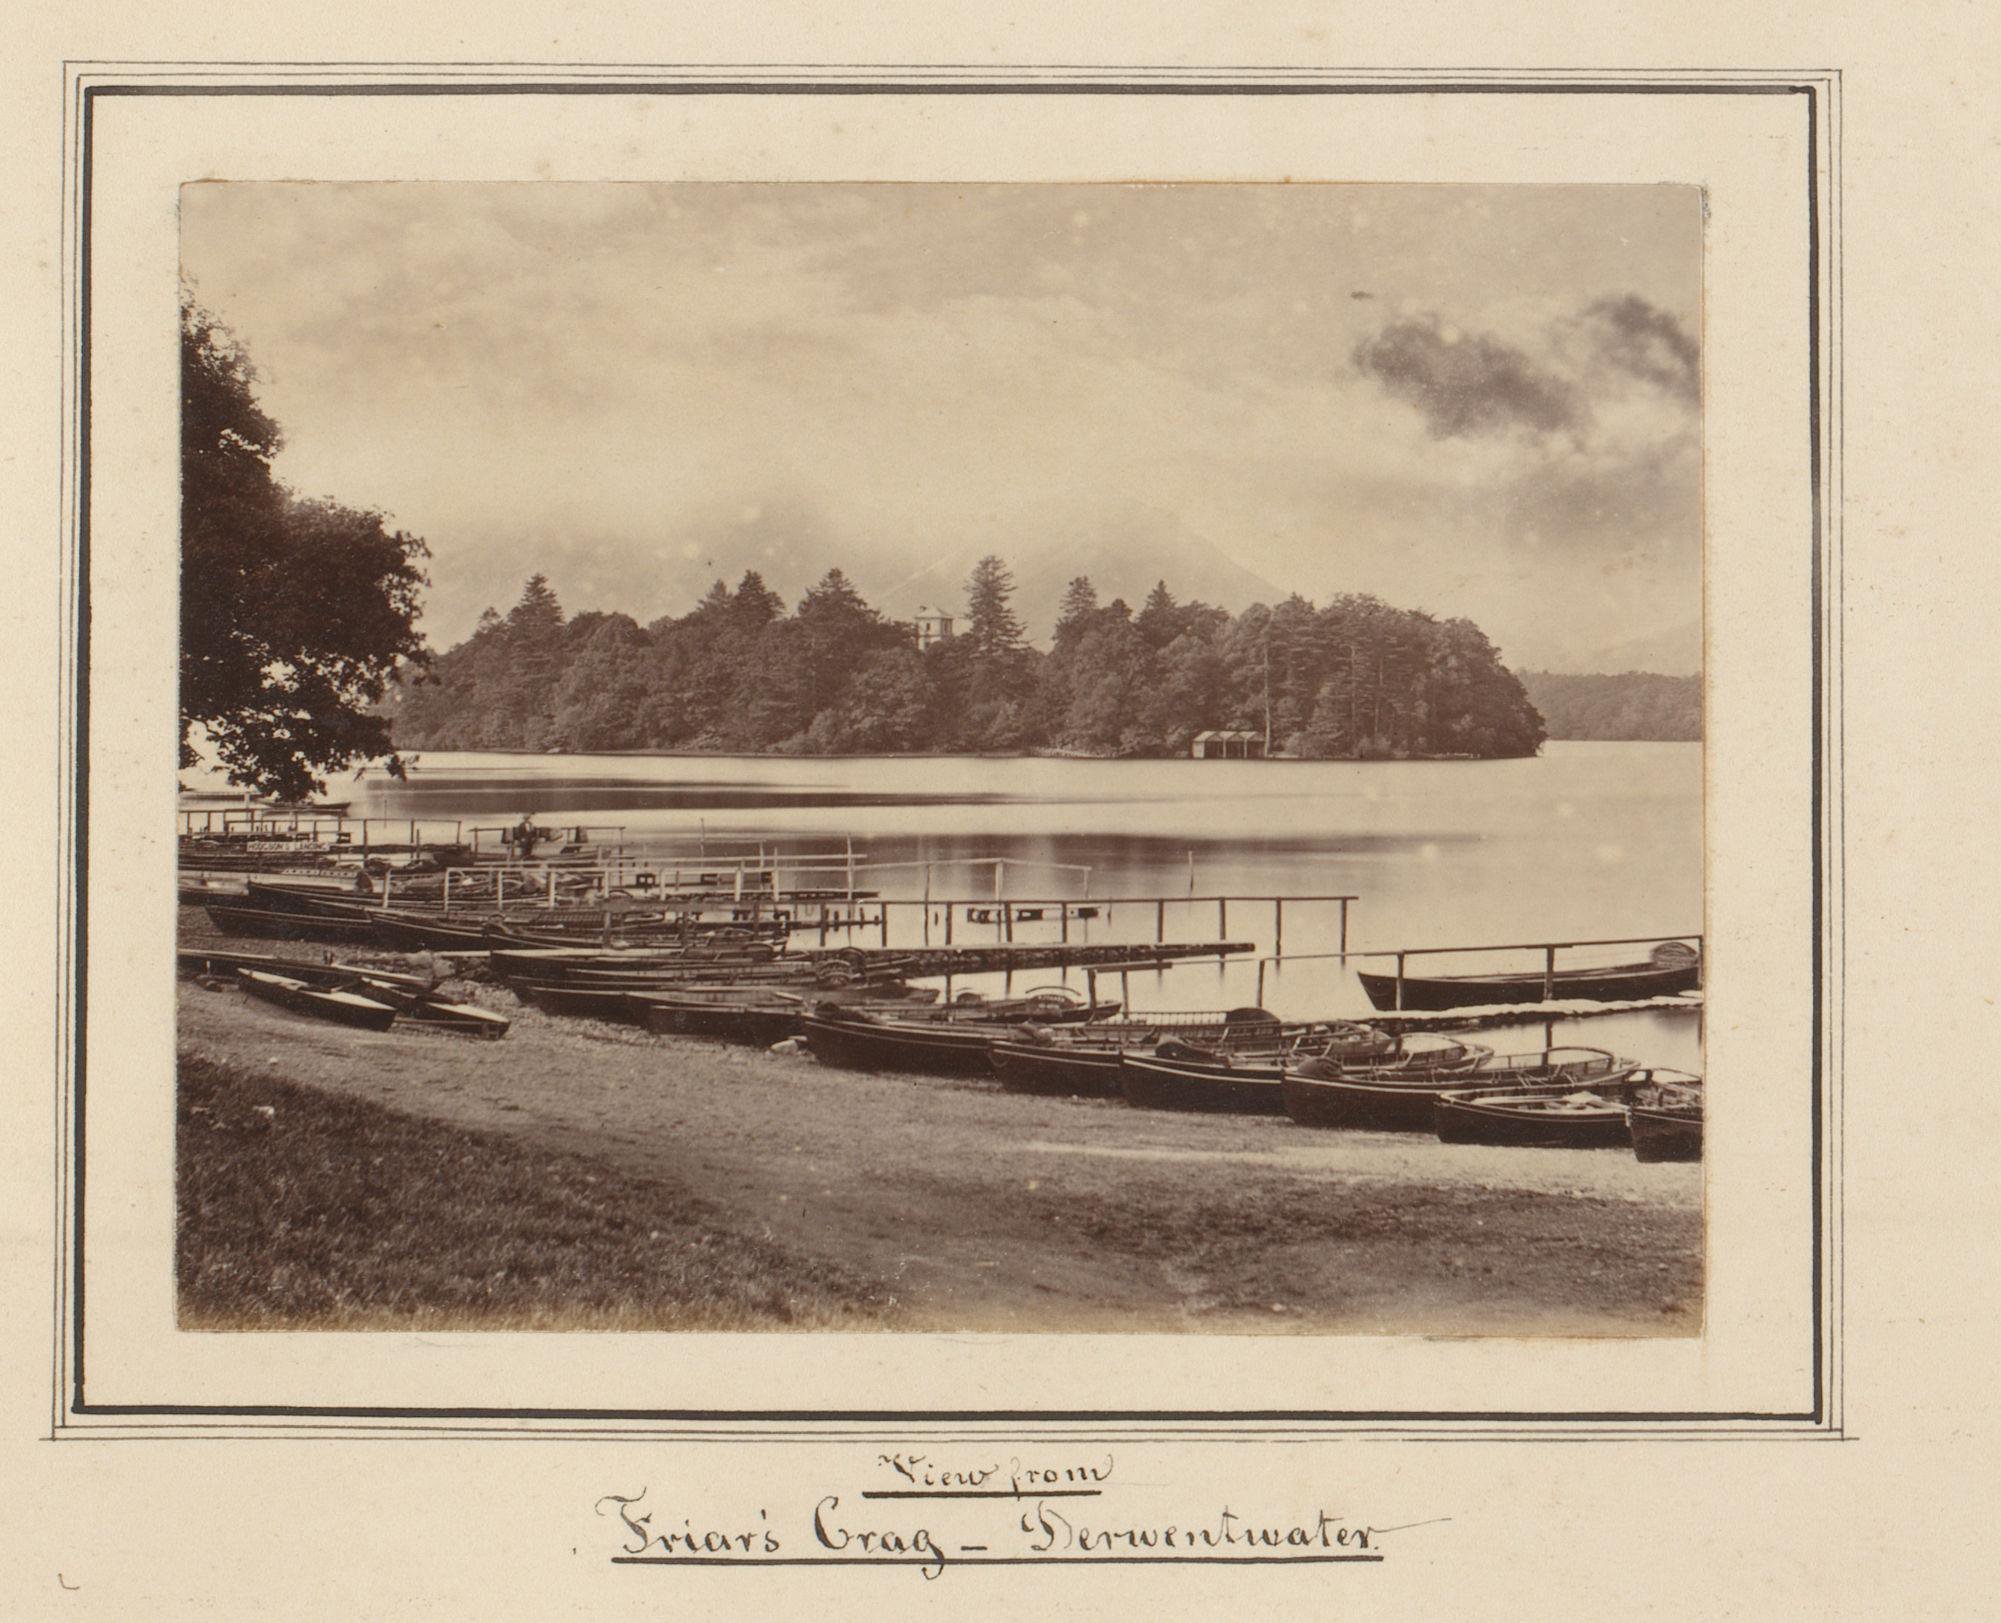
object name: photograph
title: View from Friar's Crag - Derwentwater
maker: Anonymous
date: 1870-1890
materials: paper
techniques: albumen print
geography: derwentwater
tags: lake